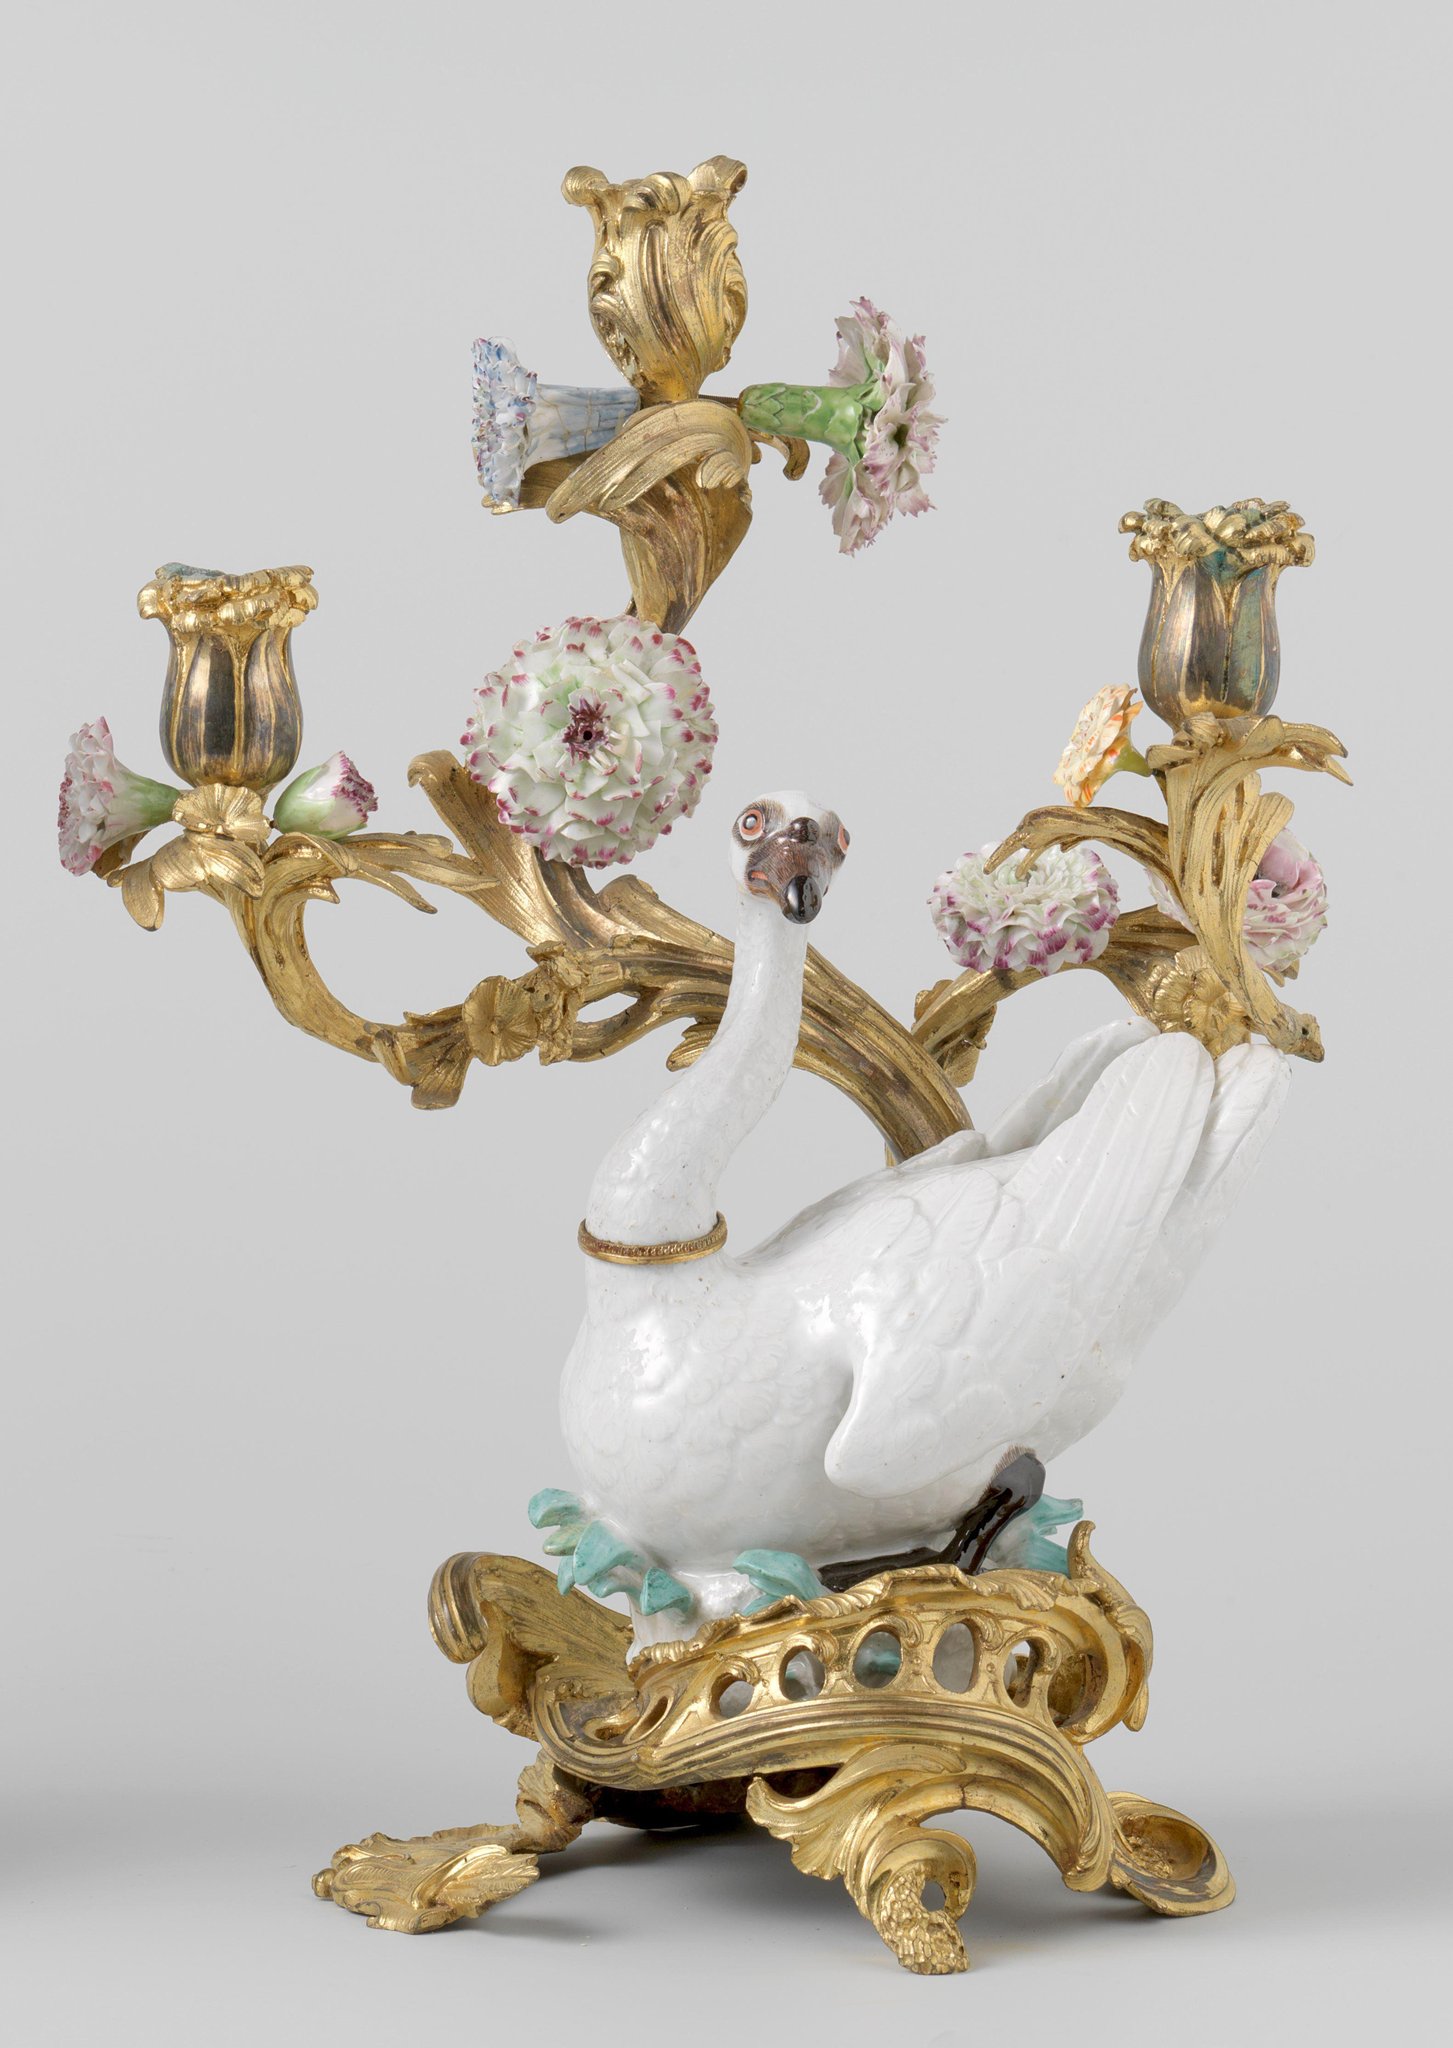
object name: candelabrum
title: Zwaan van veelkleurig beschilderd porselein,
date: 1748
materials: bronze, porcelain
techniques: gilding, painted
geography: meissen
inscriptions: factory mark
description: Zwaan van veelkleurig beschilderd porselein, op voetstuk met plastische bladversiering in blauwgroen, groen en geel. De zwaan heeft om de hals een ring van verguld brons.